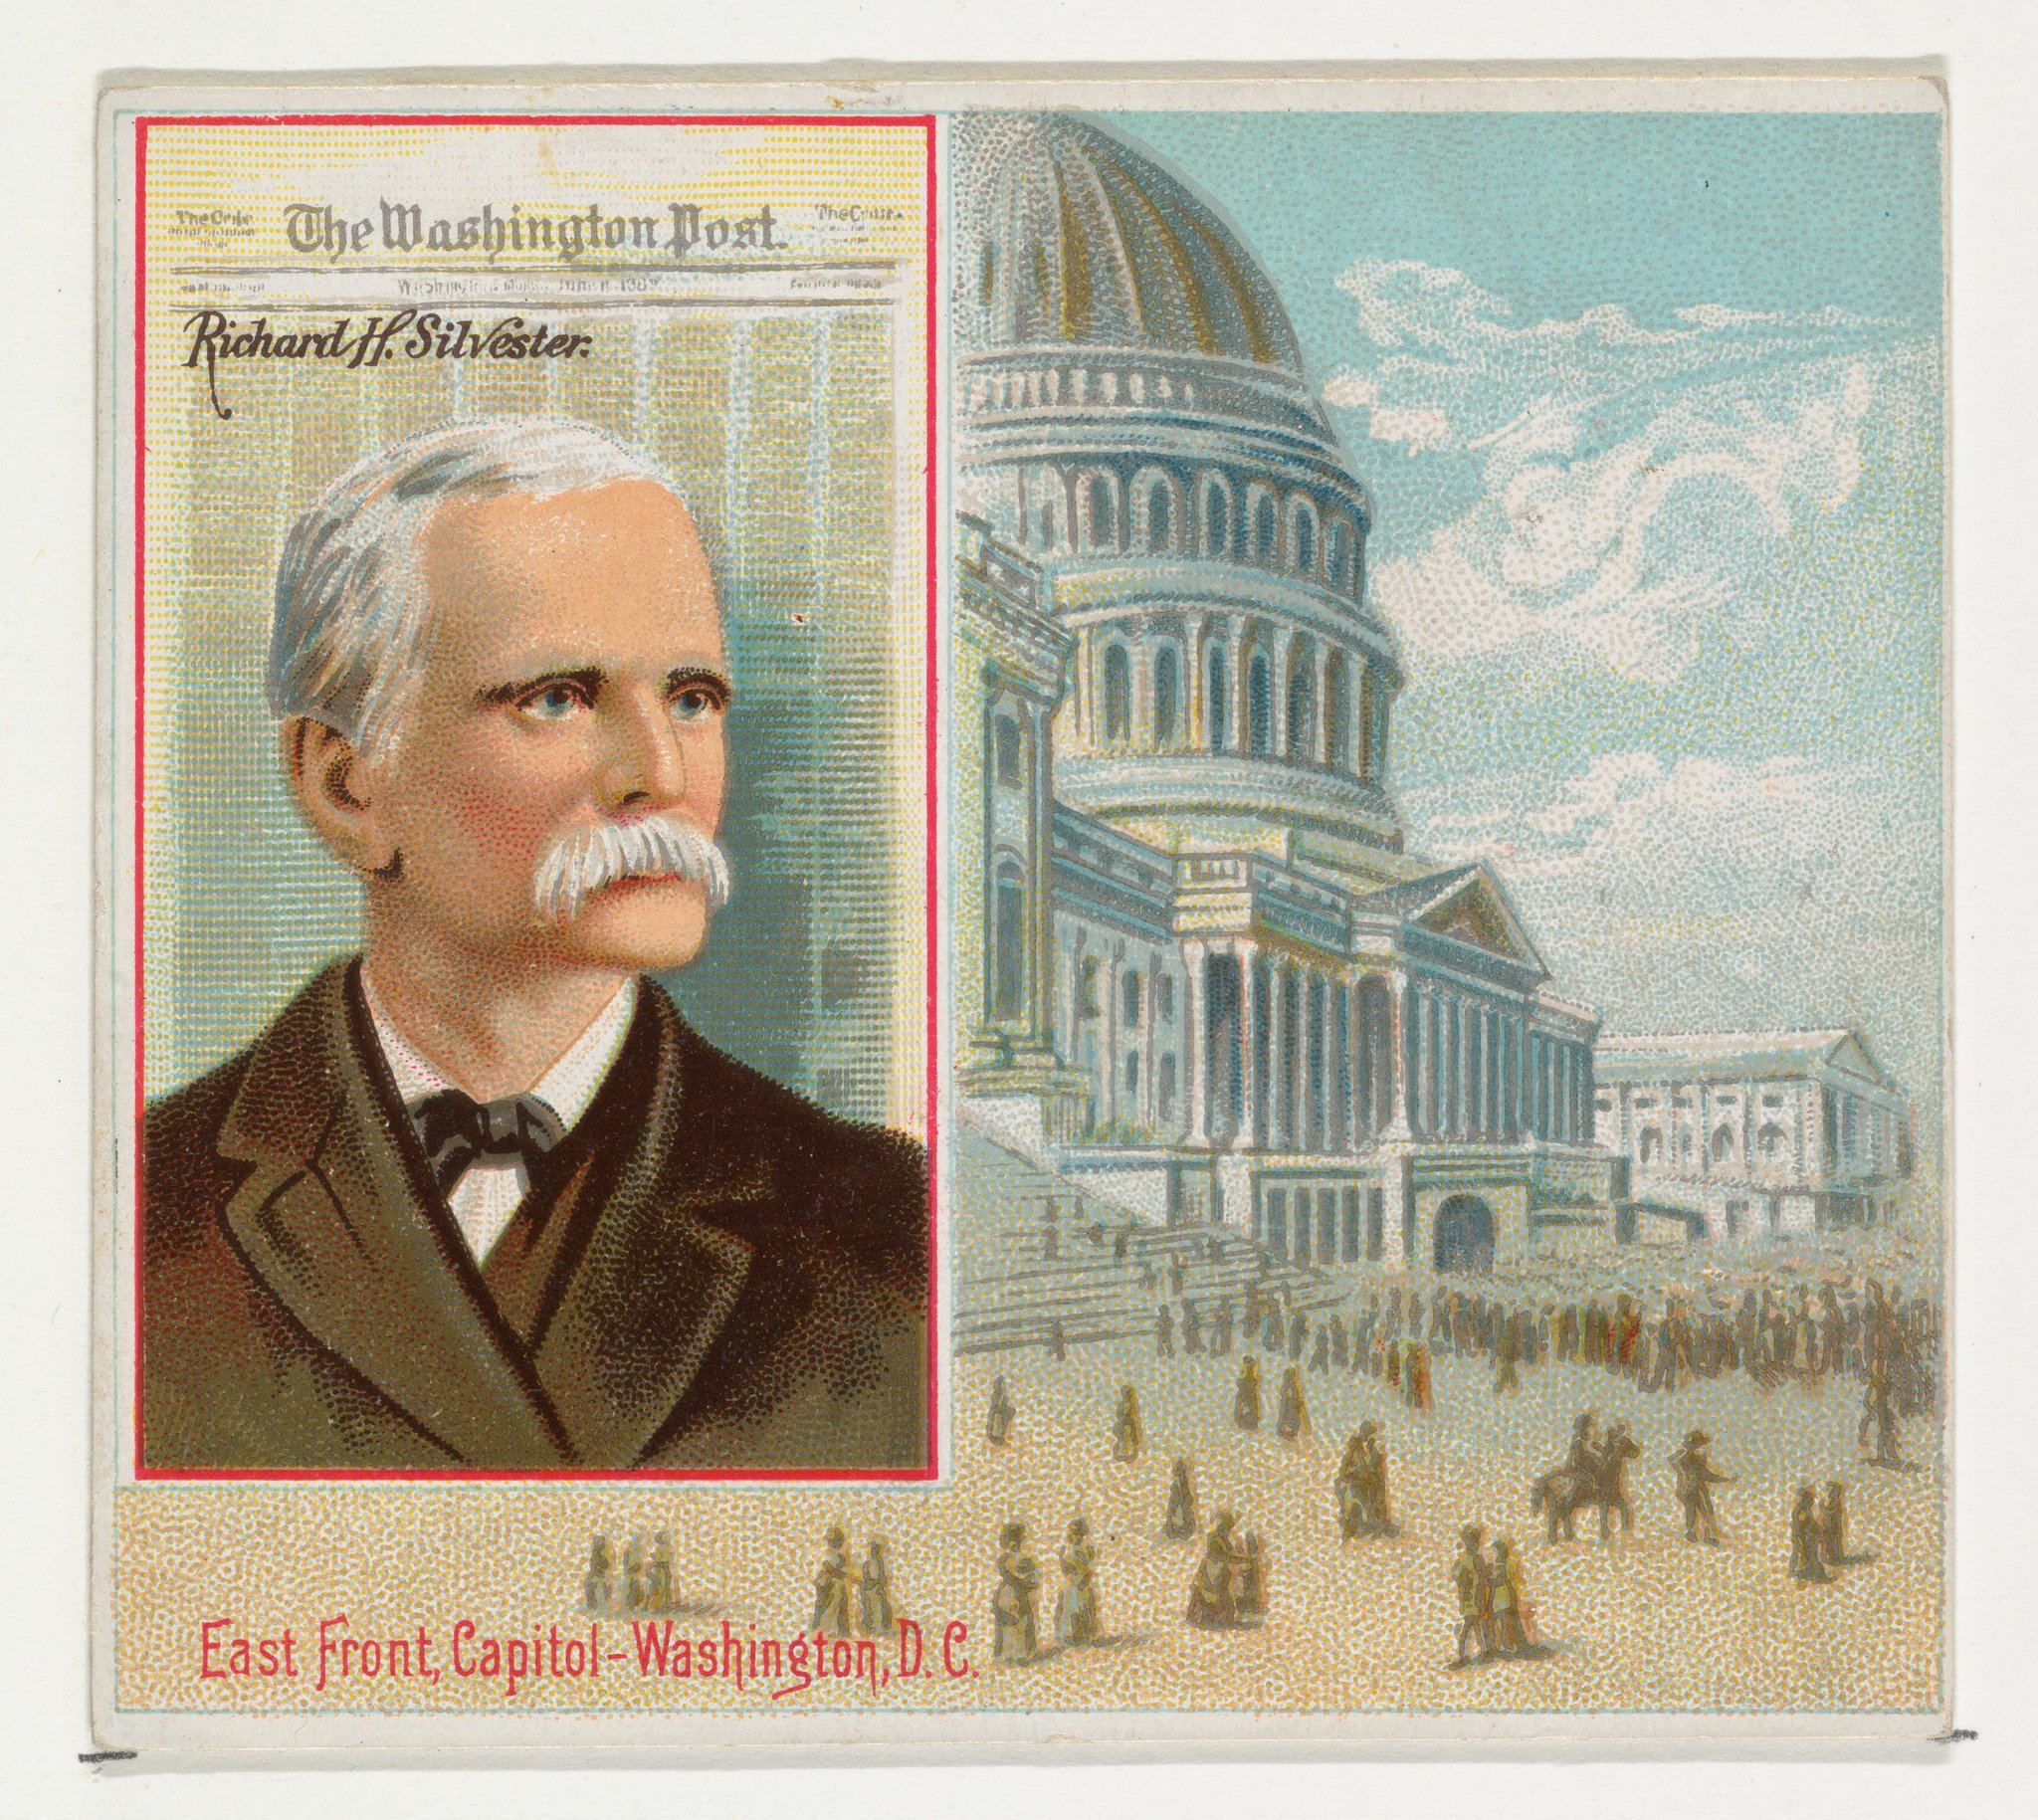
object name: print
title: Richard H. Silvester, The Washington Post, from the American Editors series (N35) for Allen & Ginter Cigarettes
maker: allen & ginter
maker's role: publisher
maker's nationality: american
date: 1887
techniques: color lithograph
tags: men,portraits